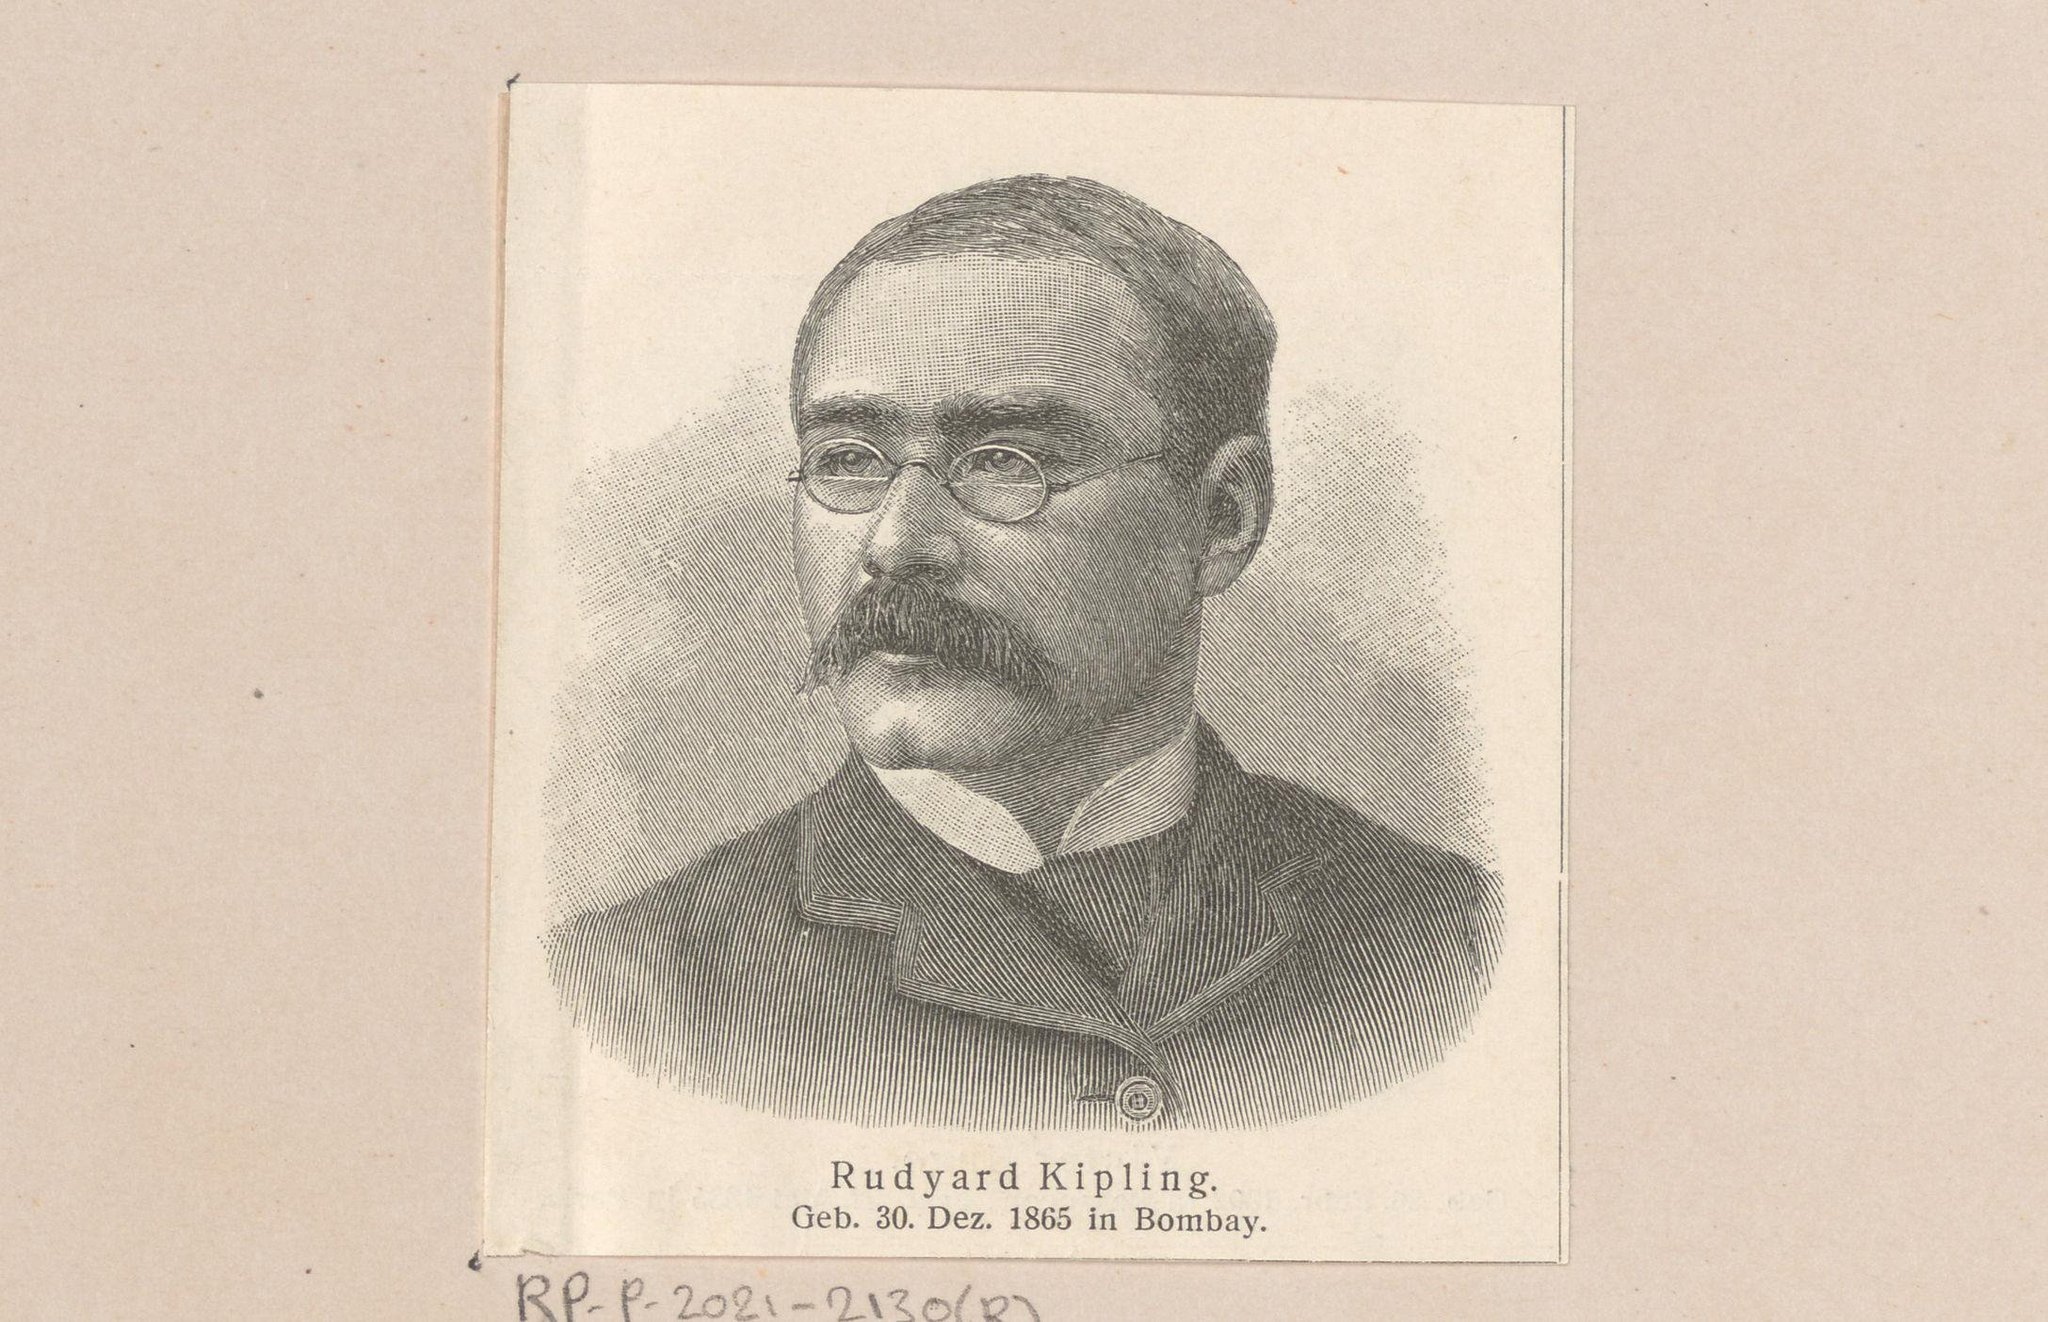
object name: print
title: Portret van Rudyard Kipling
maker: Anonymous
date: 1885-1936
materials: paper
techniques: letterpress printing, engraving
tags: historical persons, portrait of a writer